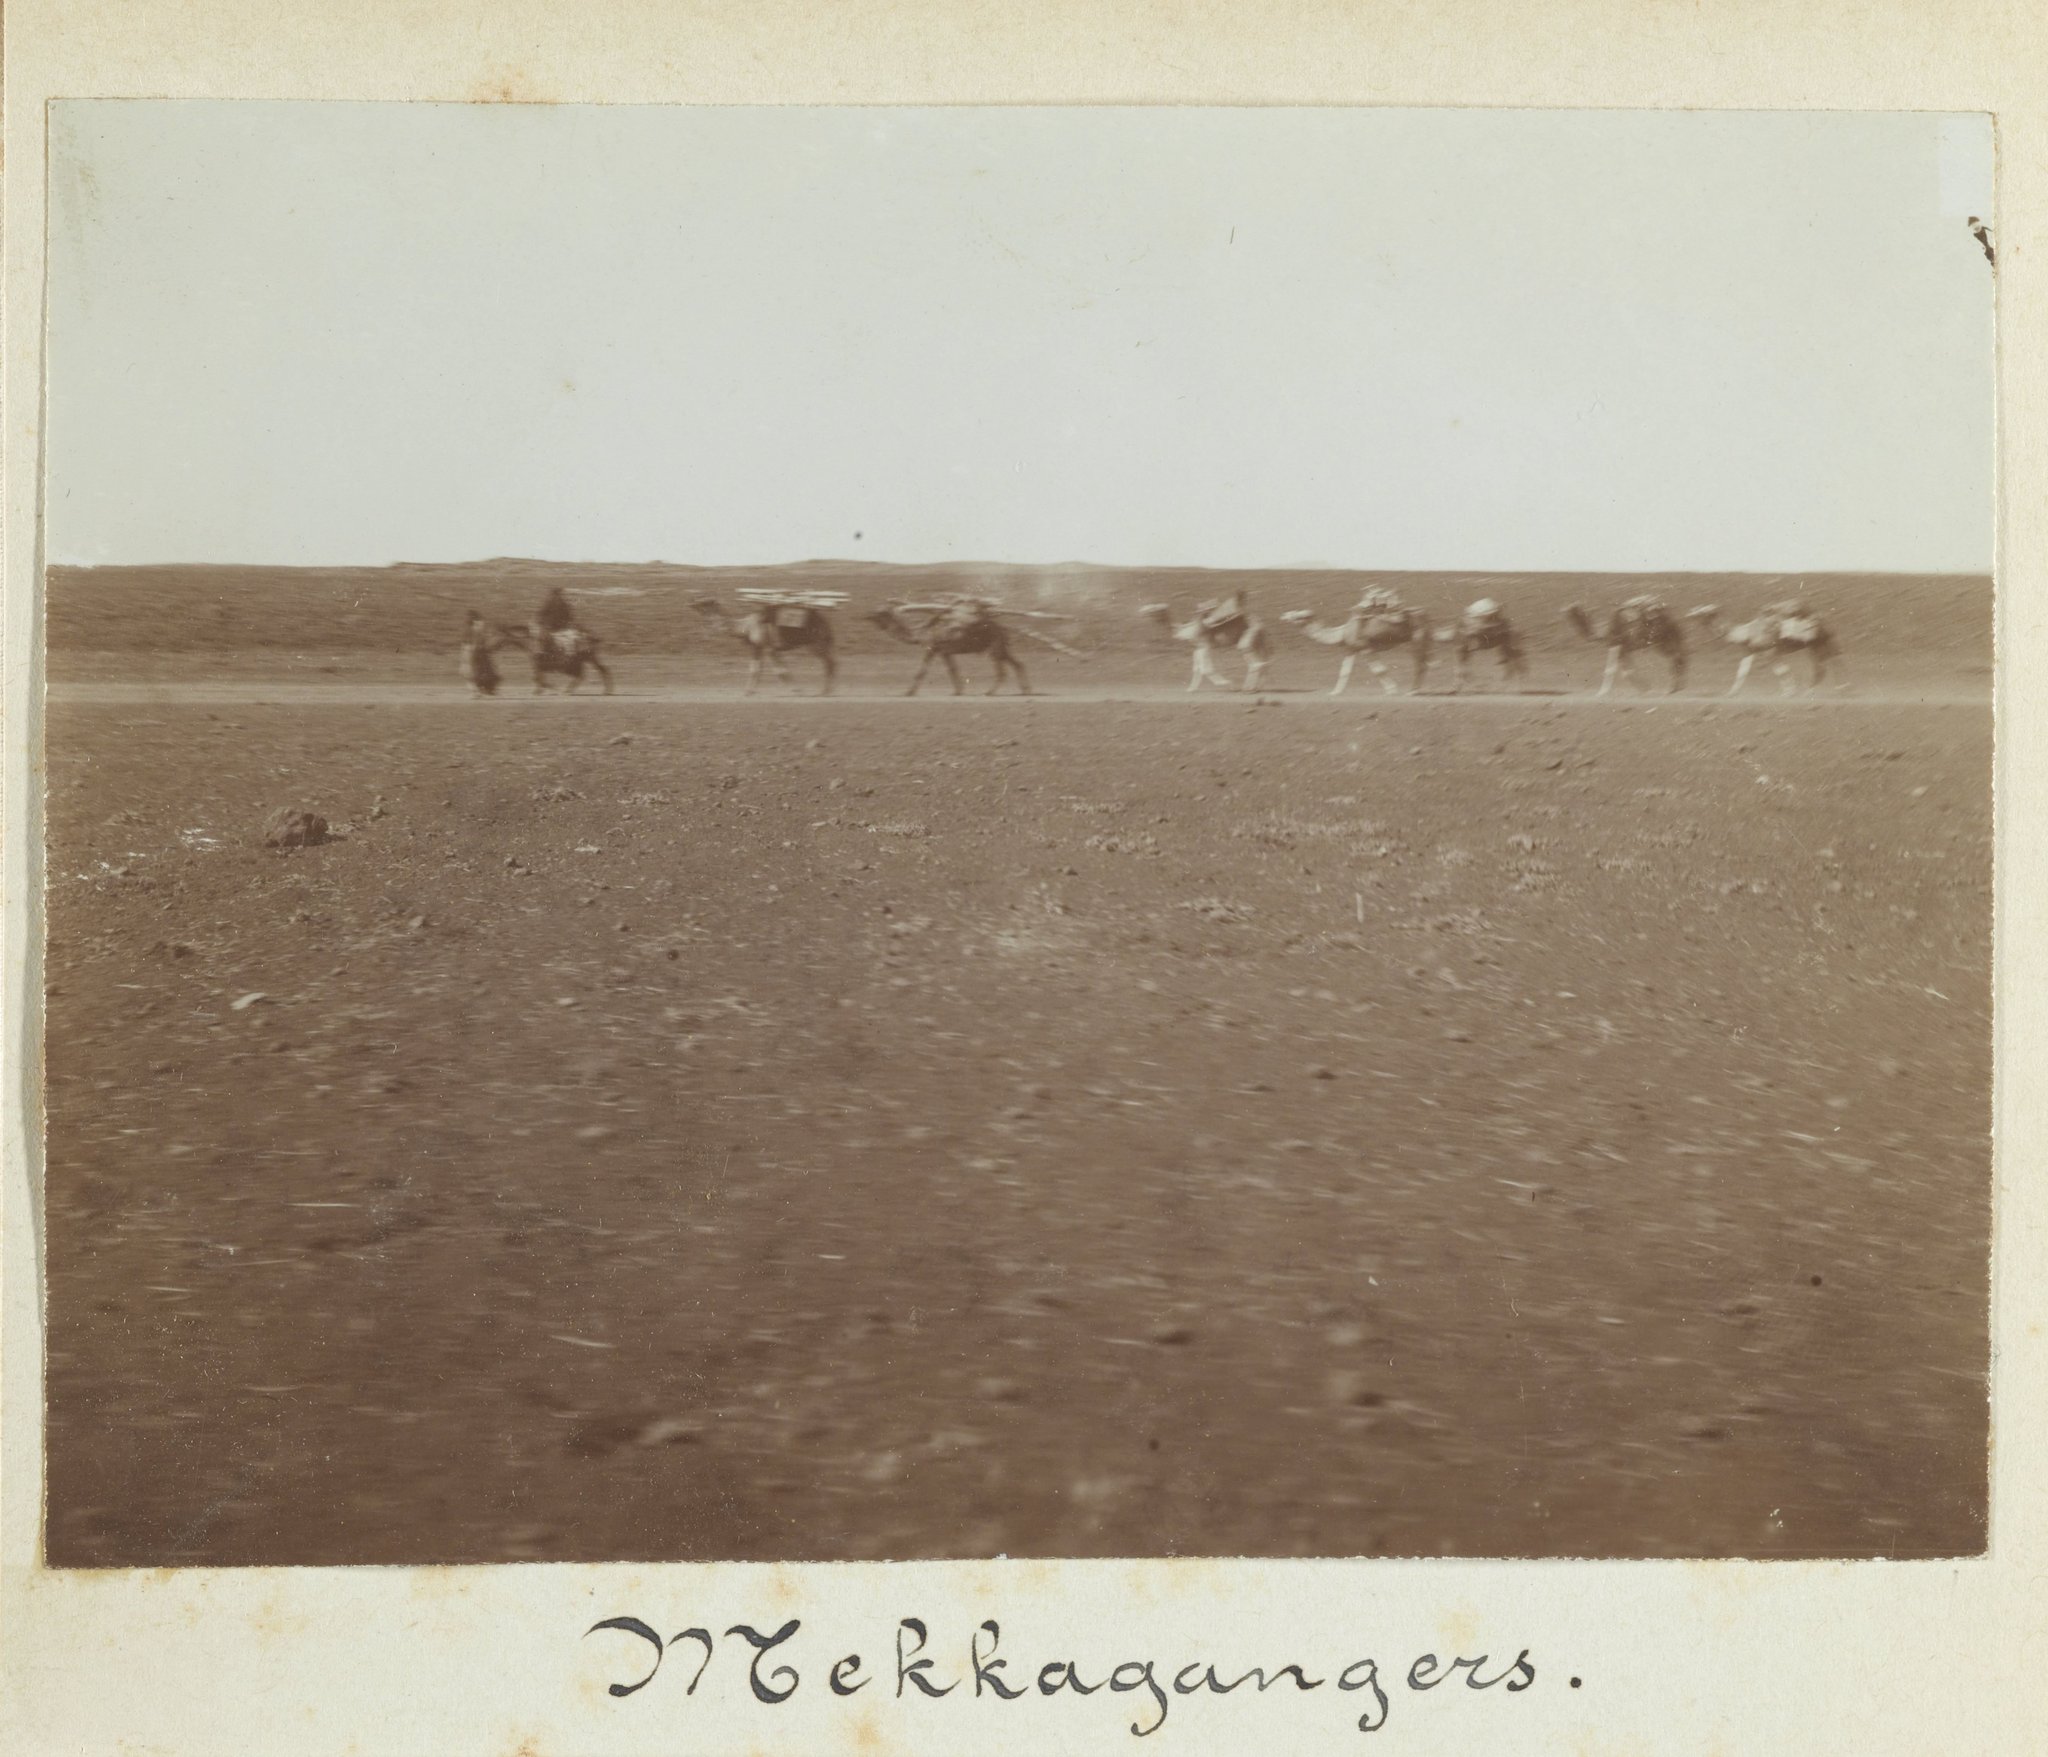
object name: photograph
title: Karavaan met negen bepakte dromedarissen in een woestijn in Syrië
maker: johannes lodewijk heldring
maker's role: fotograaf, predikant, schrijver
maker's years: 1852-1923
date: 1898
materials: paper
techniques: collodion silver print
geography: syria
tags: hoofed animals: dromedary, desert